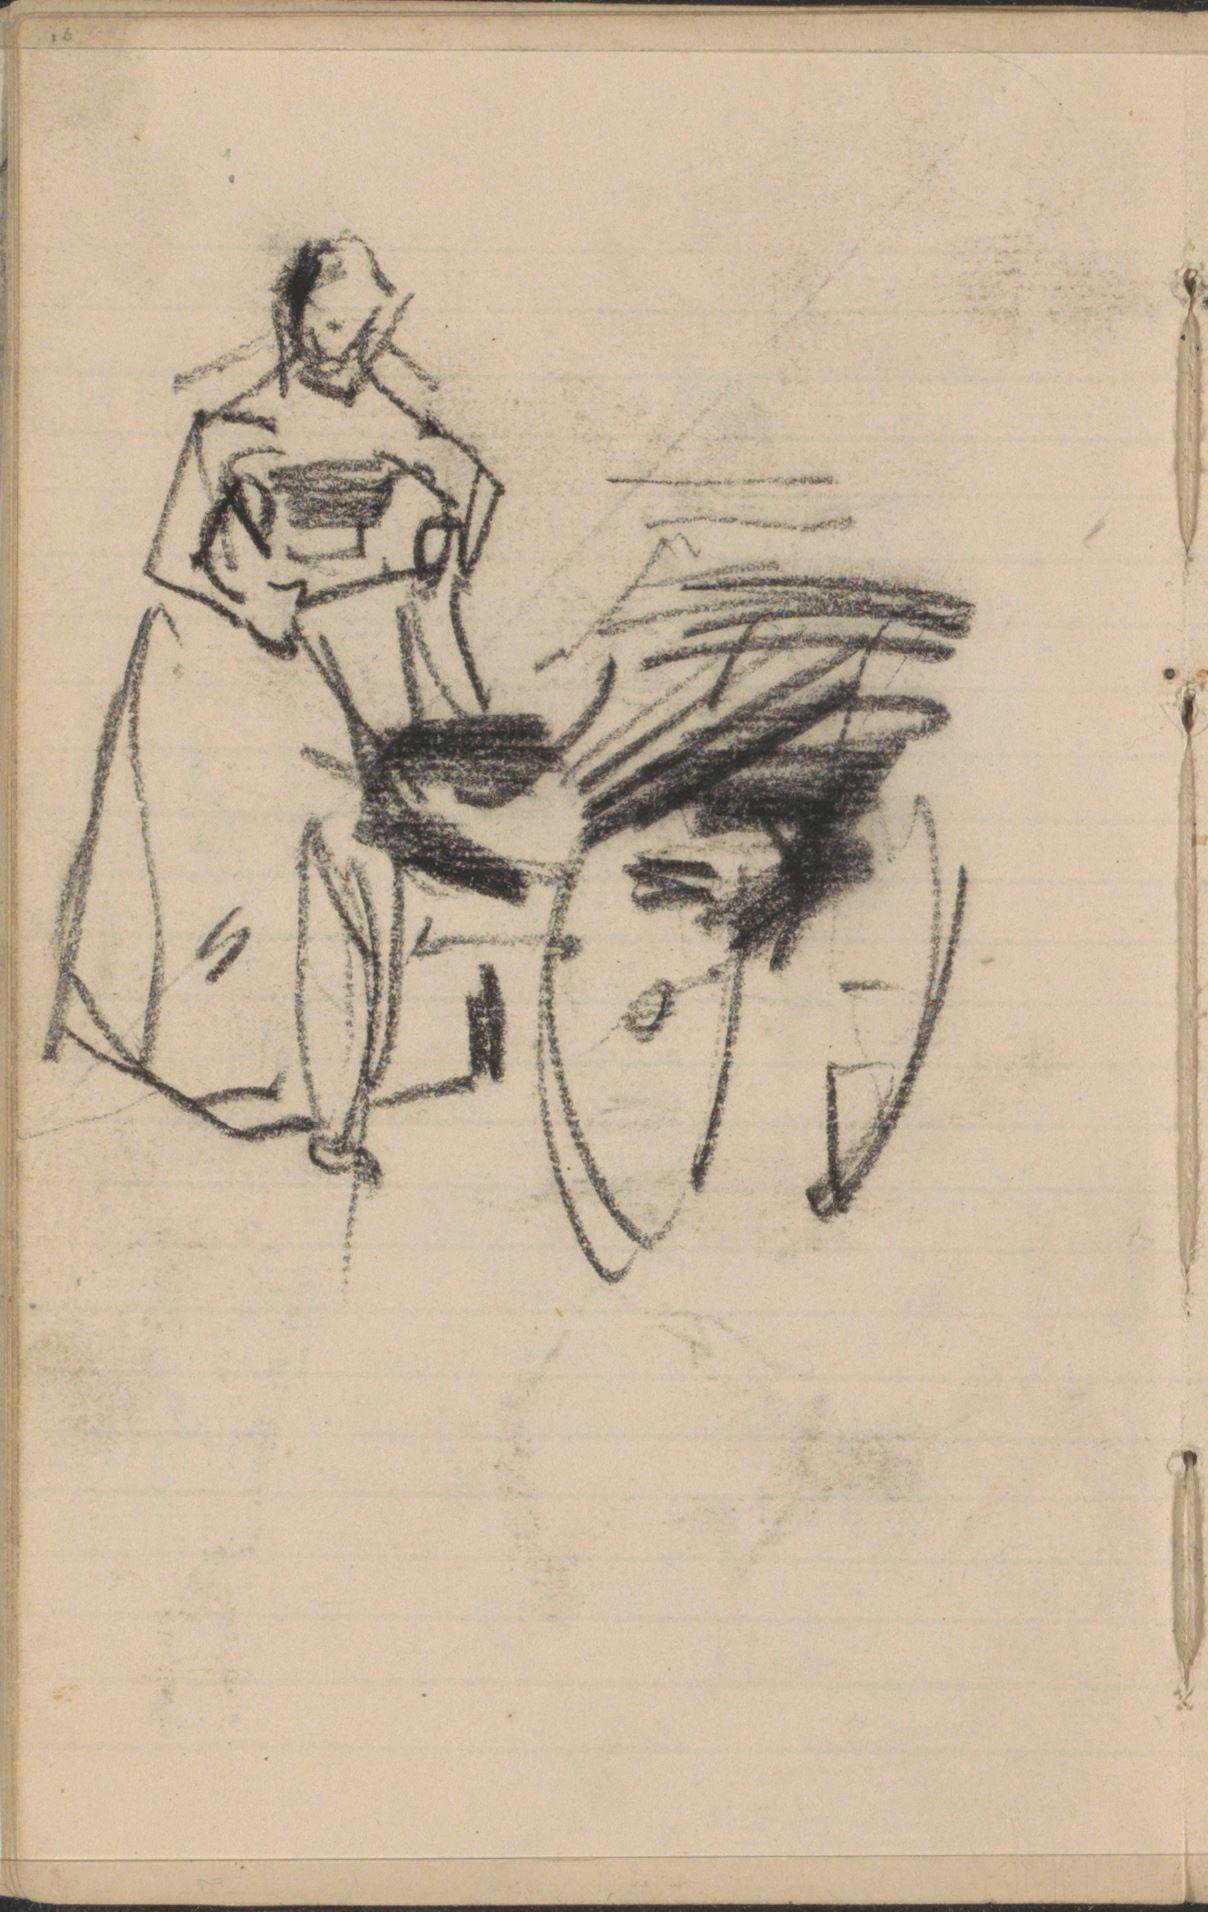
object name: sketchbook leaf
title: Vrouw met een kinderwagen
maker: marius bauer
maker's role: draughtsman, print maker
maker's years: 1867-1932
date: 1881-1885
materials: chalk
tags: baby-carriage, pram, perambulator, adult woman, walking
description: Pagina 16 uit een schetsboek met 26 bladen.